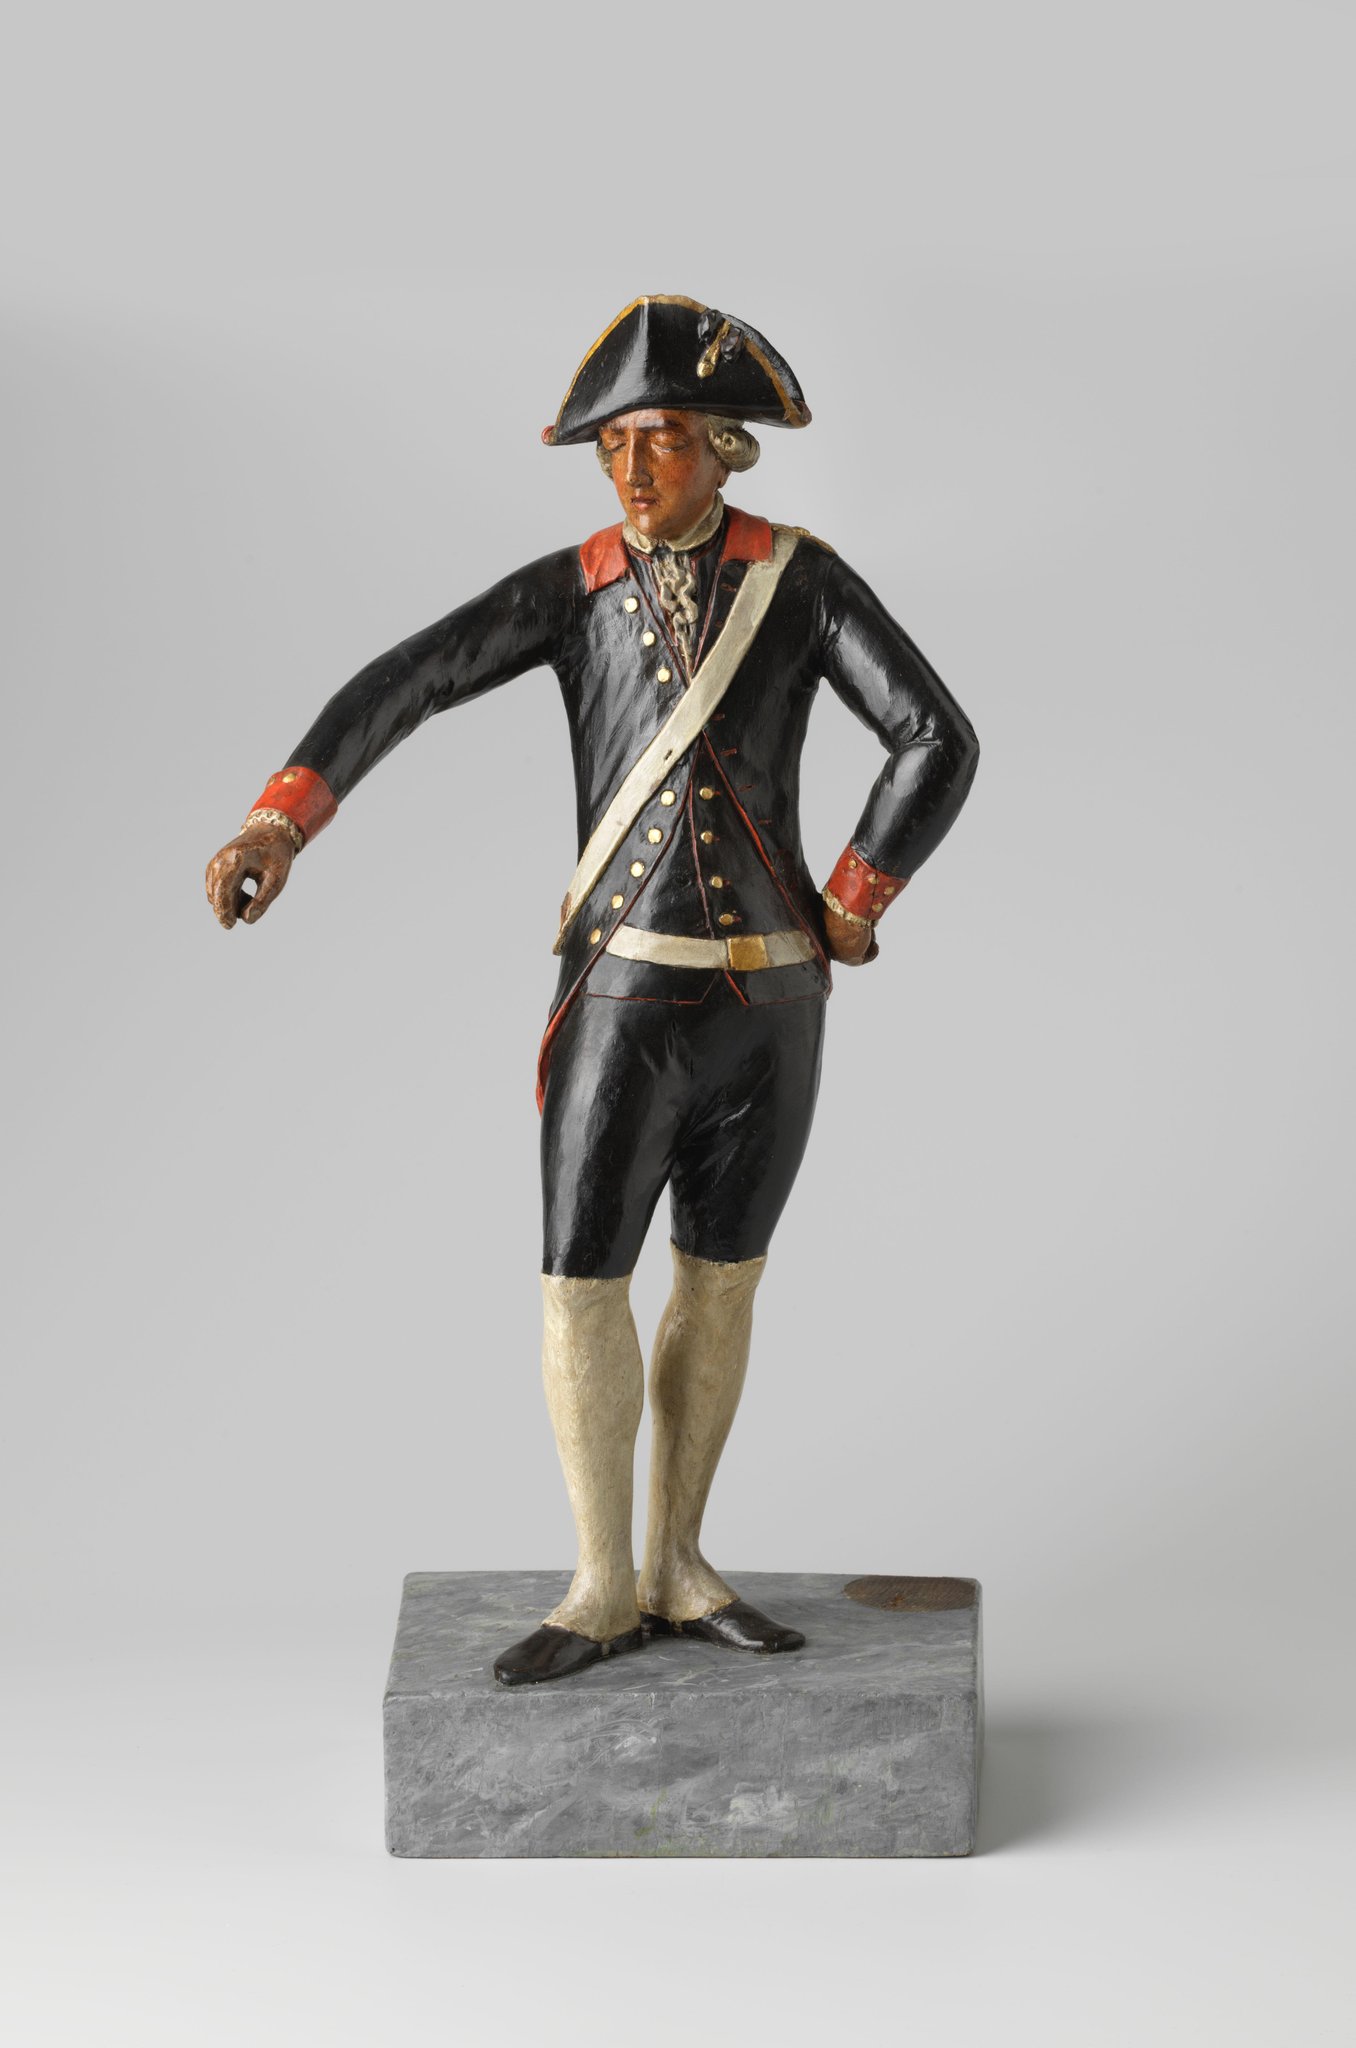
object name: sculpture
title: Kanonnierschutter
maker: Anonymous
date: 1795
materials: wood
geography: northern netherlands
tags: military service (+ artillery)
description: Houten beeldje van een kanonierschutter in een uniform van 1795, bezig om de lont in het kruit te steken. Het beeldje is geverfd met de oorspronkelijke kleuren.